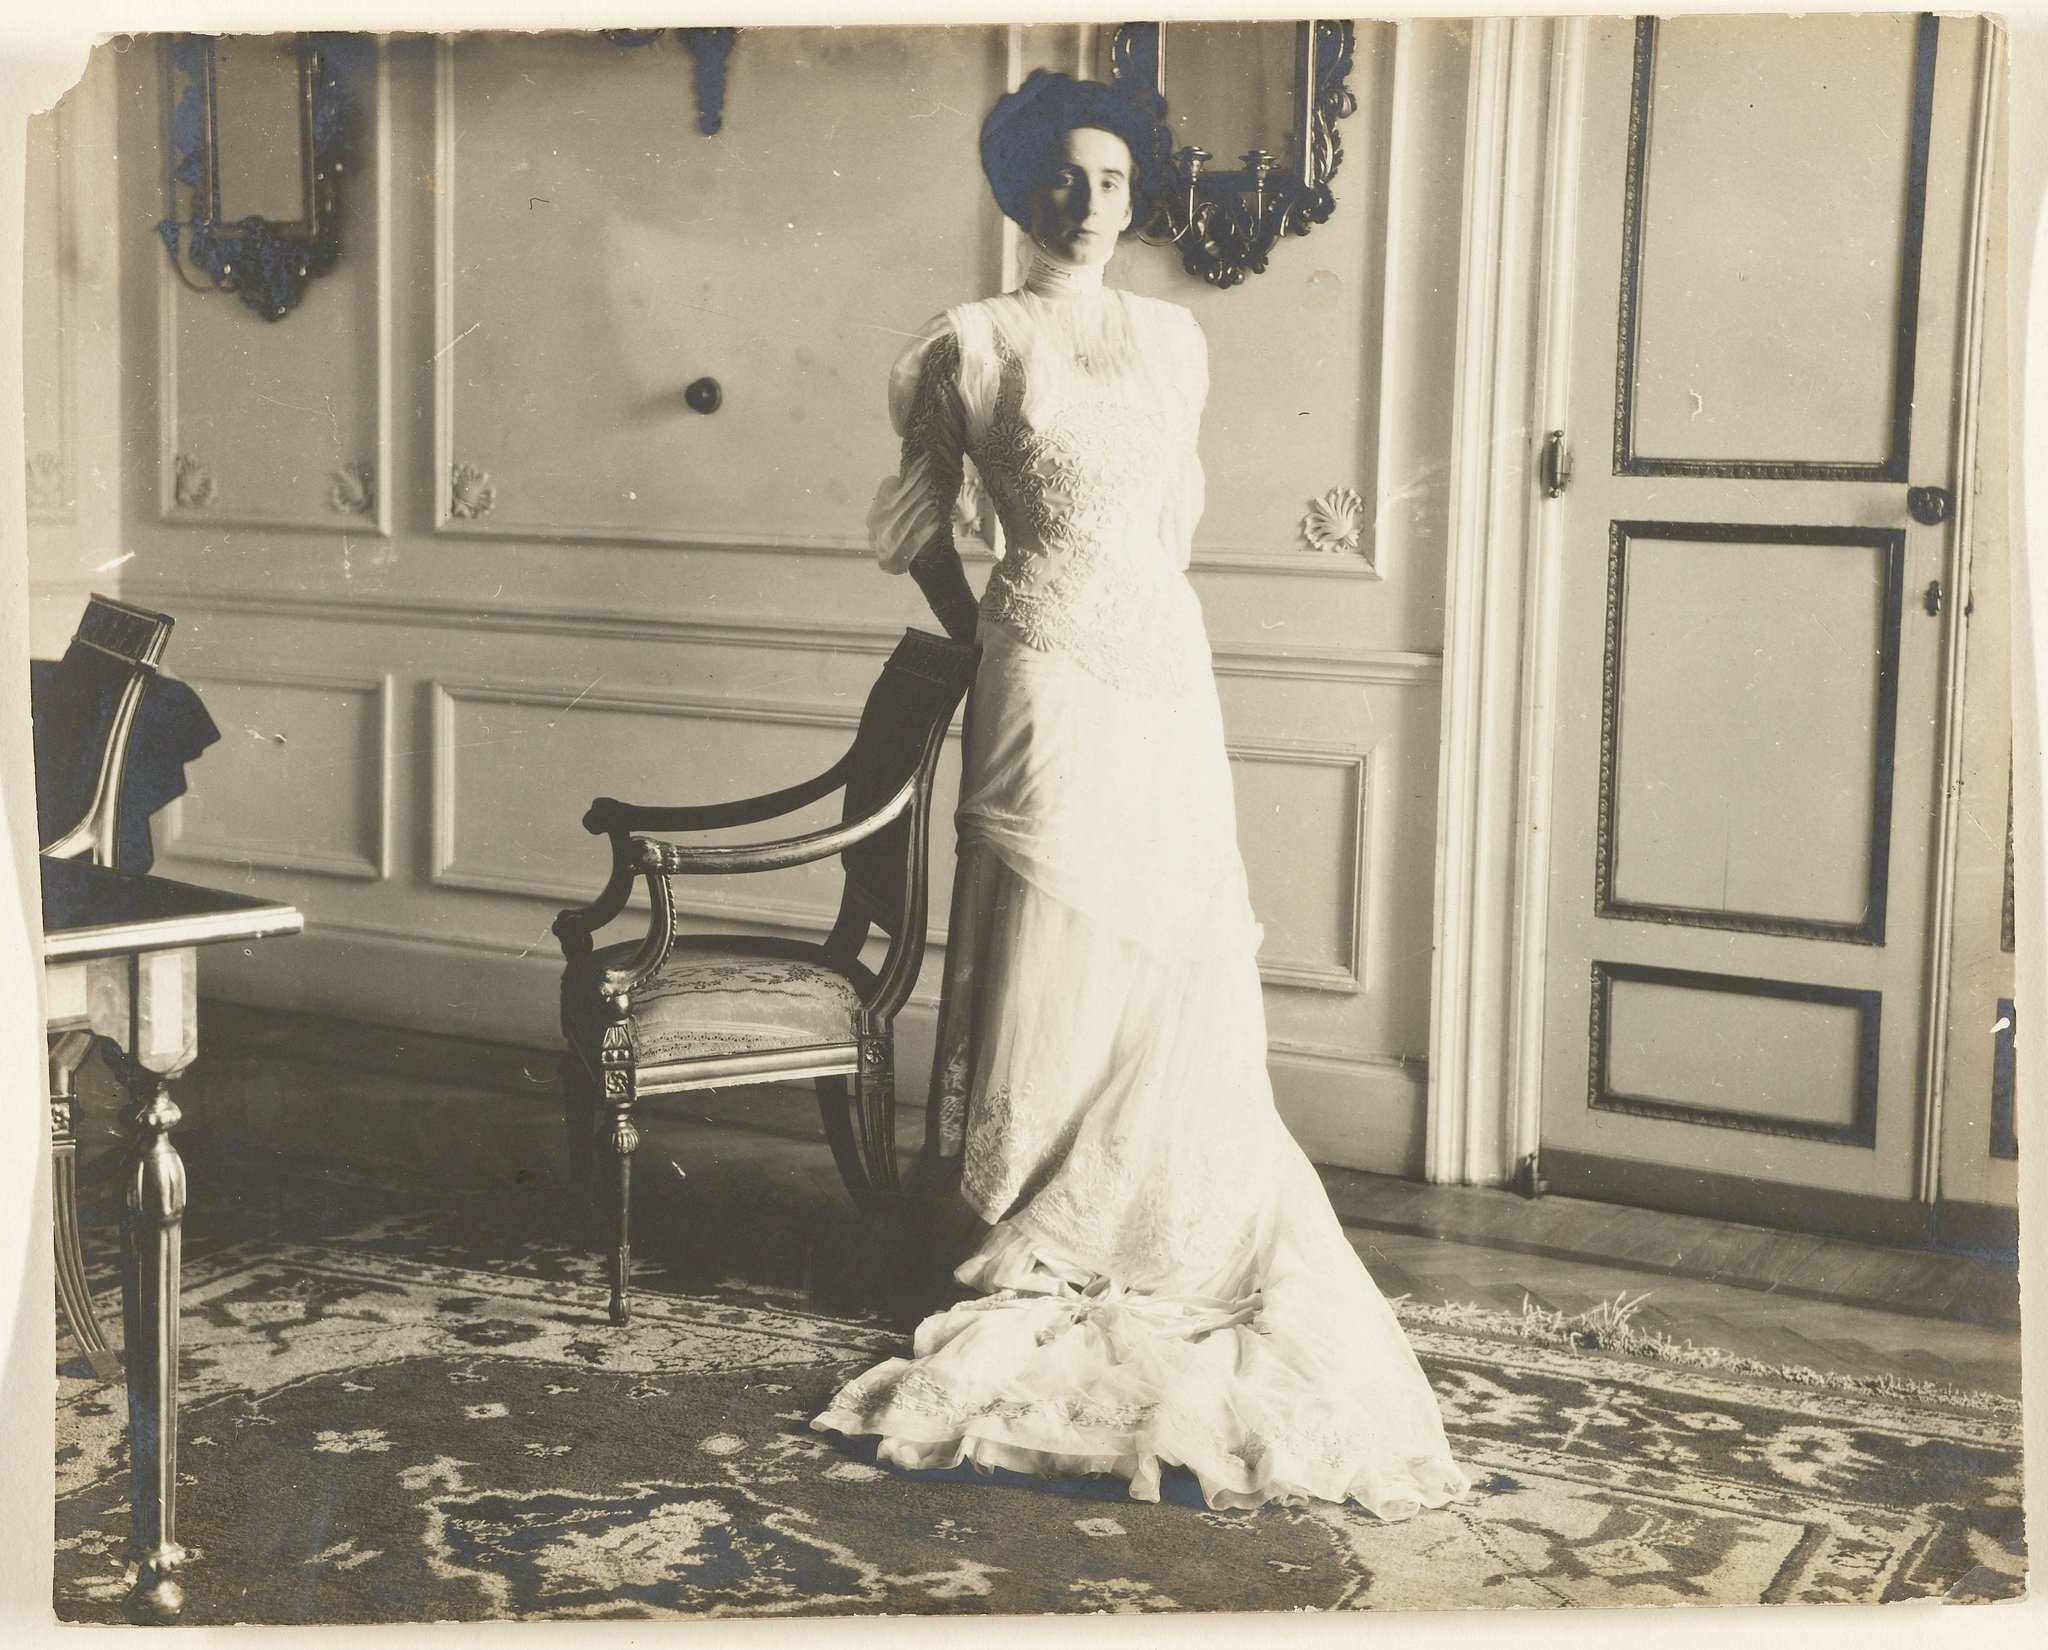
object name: photograph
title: Portret van een onbekende vrouw staand in een interieur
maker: Anonymous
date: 1918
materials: paper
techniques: gelatin silver print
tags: communal rooms, anonymous historical person portrayed - bb - woman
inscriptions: inscription: ‘Salon 18 Italie/ Januar 1918’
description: Foto uit een serie van 6. Mogelijk 18, Boulevard d’Italie, Parijs.